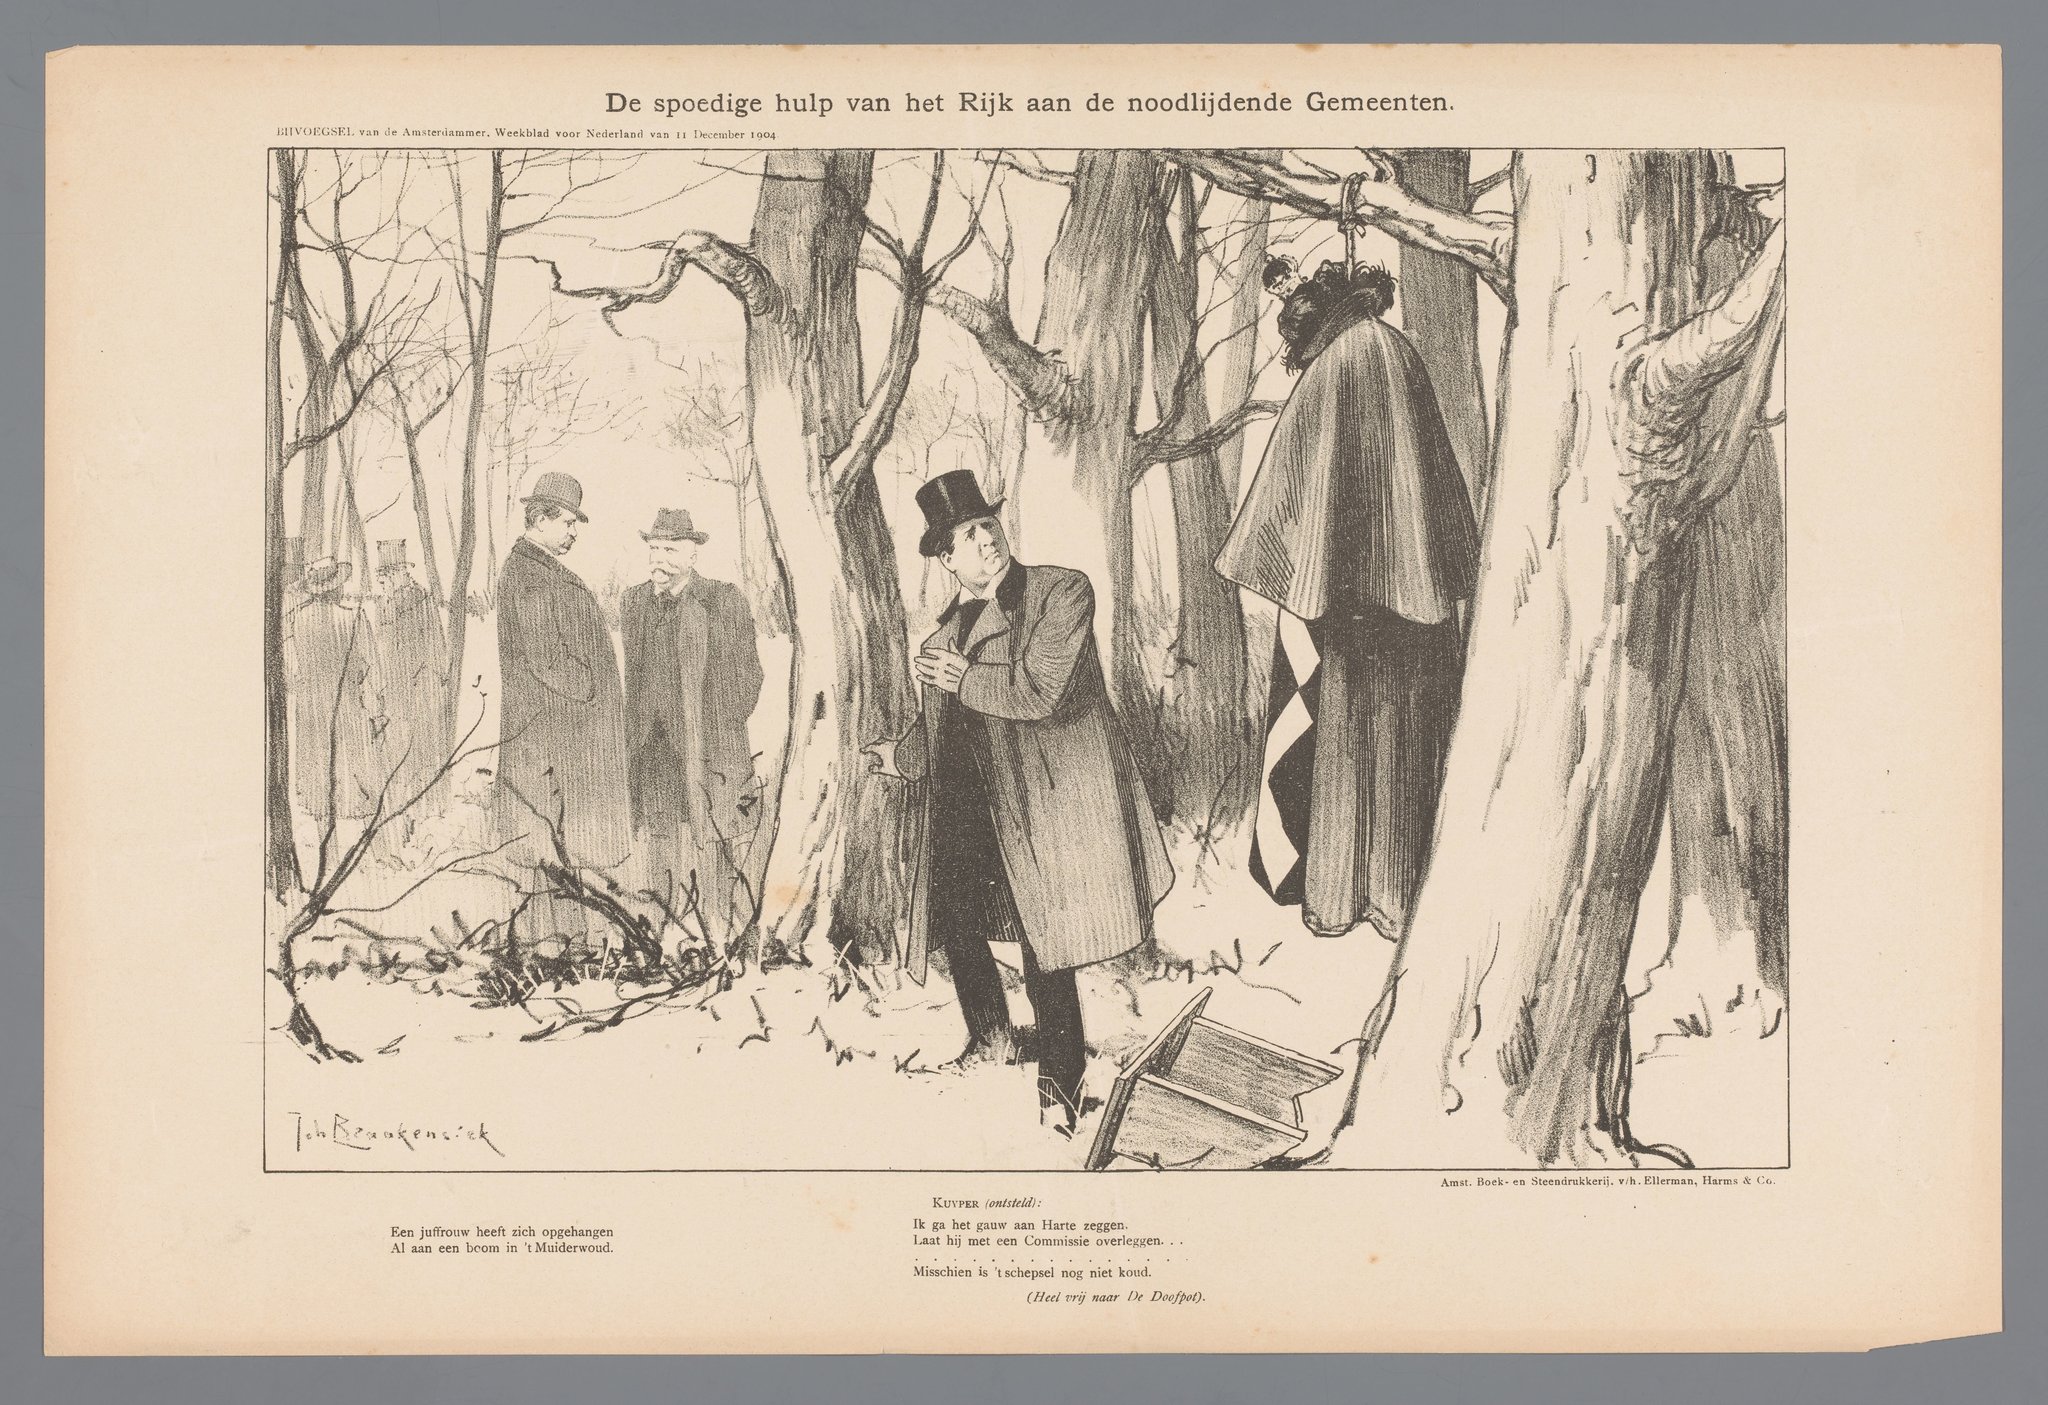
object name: cartoon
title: De spoedige hulp van het Rijk aan de noodlijdende Gemeenten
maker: johan braakensiek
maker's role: draughtsman, print maker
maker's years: 1858-1940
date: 1904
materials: paper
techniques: lithograph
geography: amsterdam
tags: the hague, abraham kuyper, violent death by hanging, historical persons, political caricatures and satires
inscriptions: date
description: Prent uit het bijvoegsel van: De Amsterdammer. Weekblad voor Nederland, 11 december 1904.